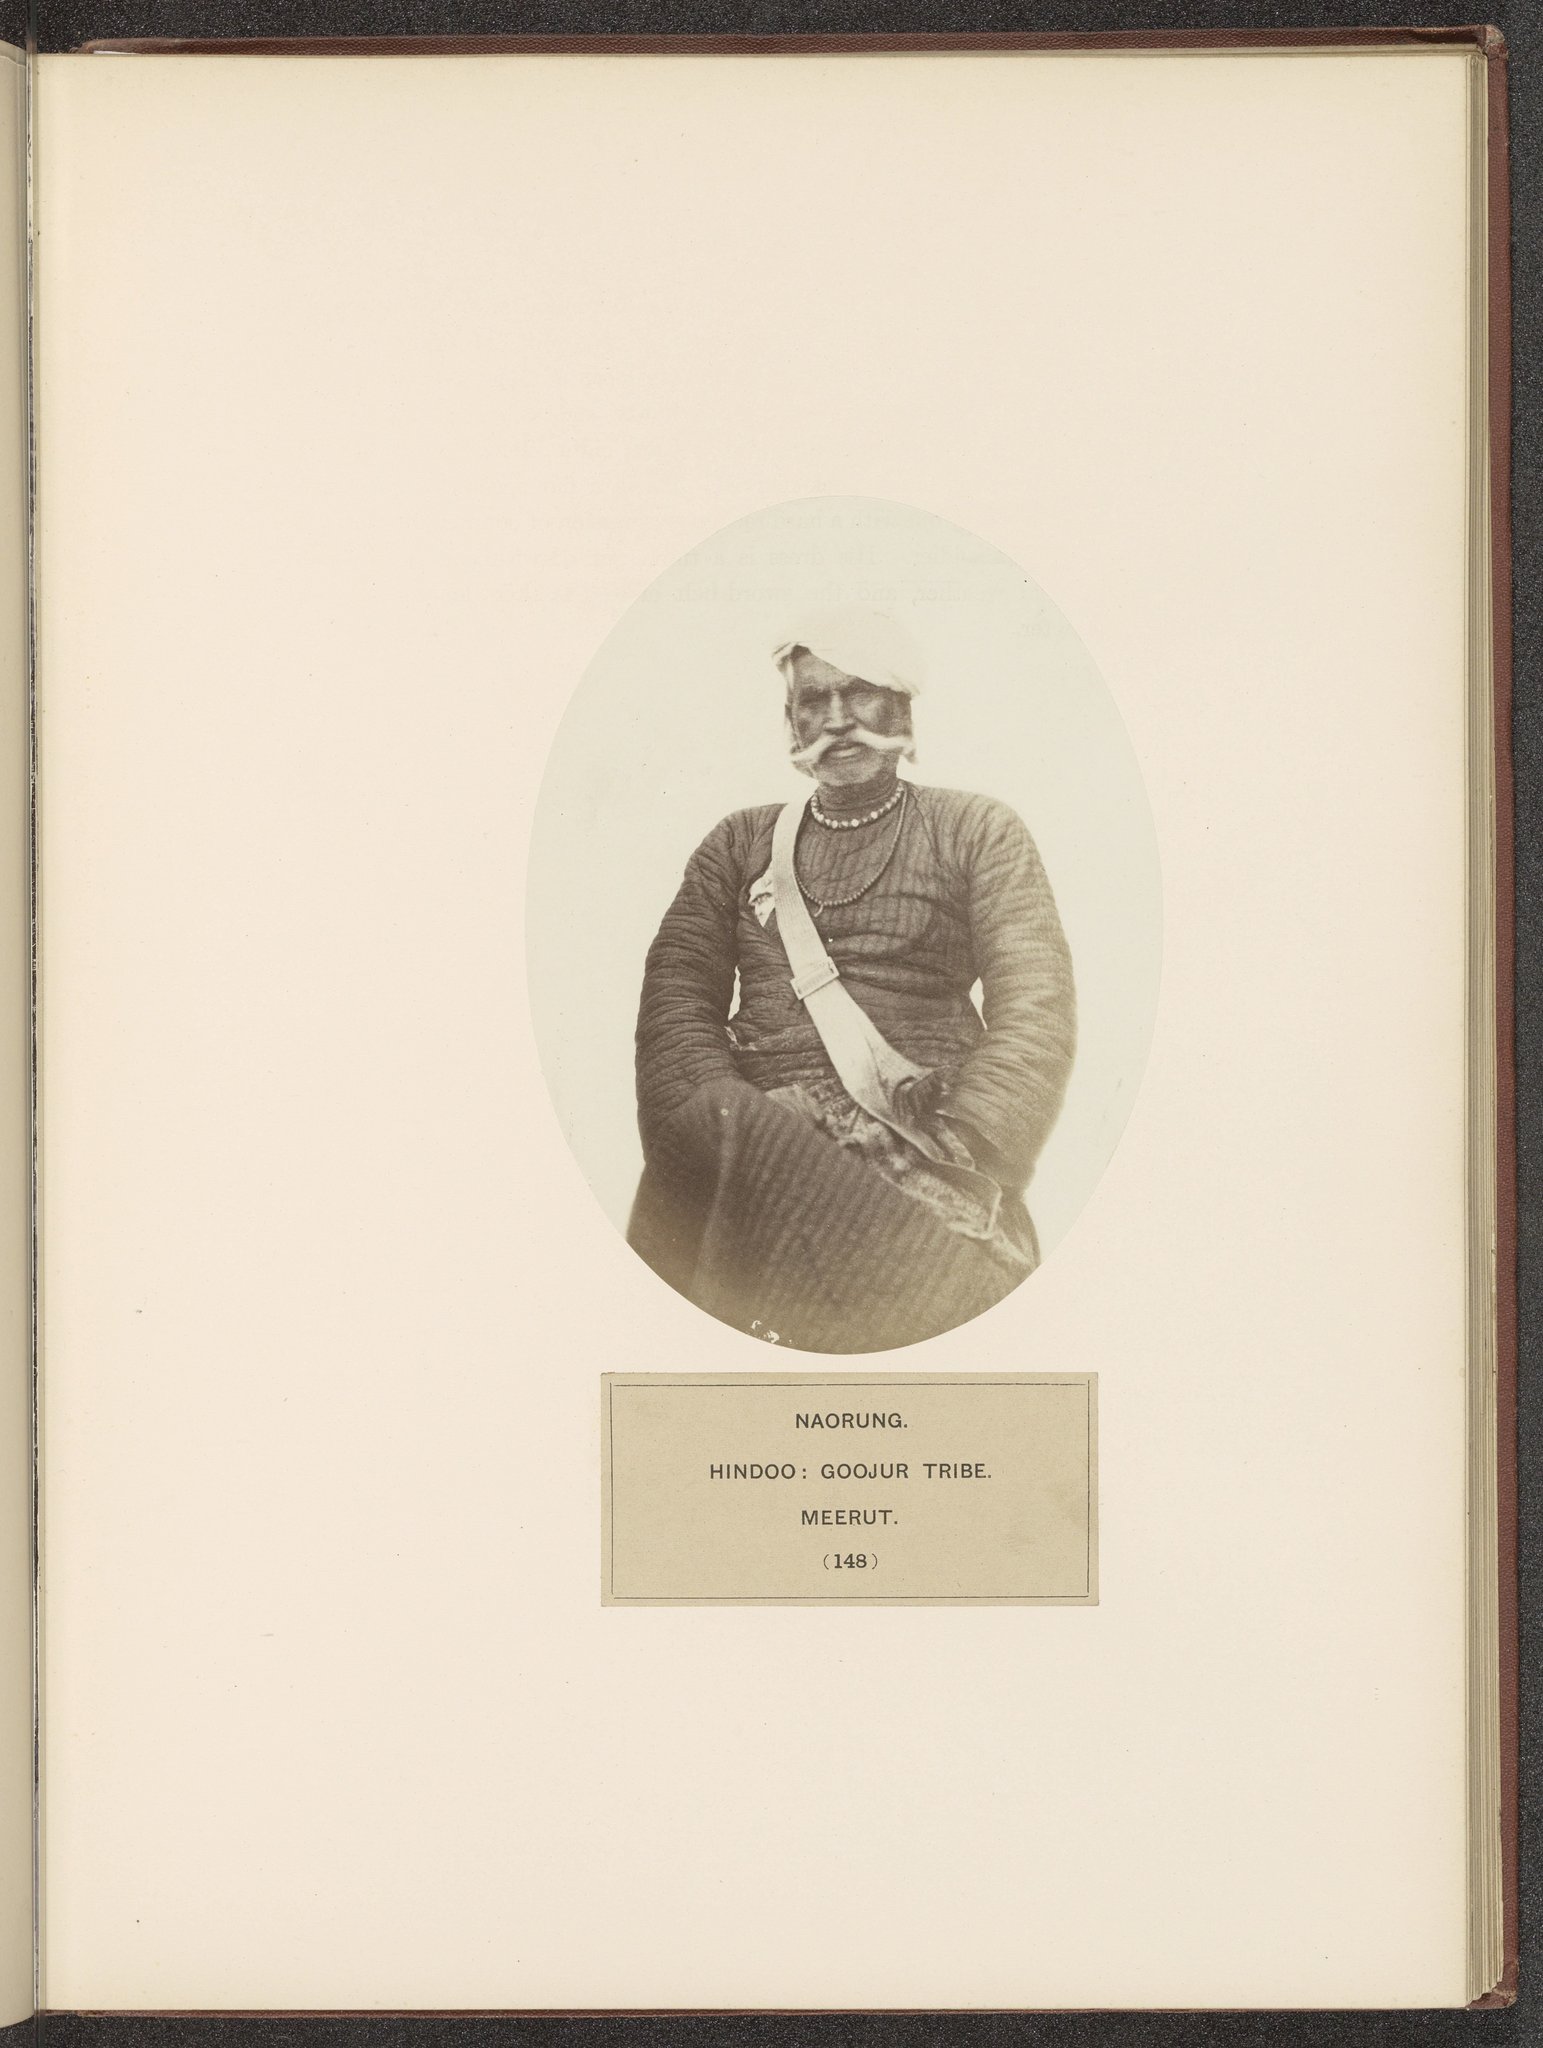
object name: page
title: Portrait of Naorung, a man from the Gurjar community of Meerut, Uttar Pradesh, India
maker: Anonymous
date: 1858-1868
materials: photographic support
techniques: albumen print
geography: meerut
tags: head-gear: turban, human races; peoples; nationalities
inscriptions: inscription: ‘NAORUNG./ HINDOO: GOOJUR TRIBE./ MEERUT.’, number: ‘(148)’